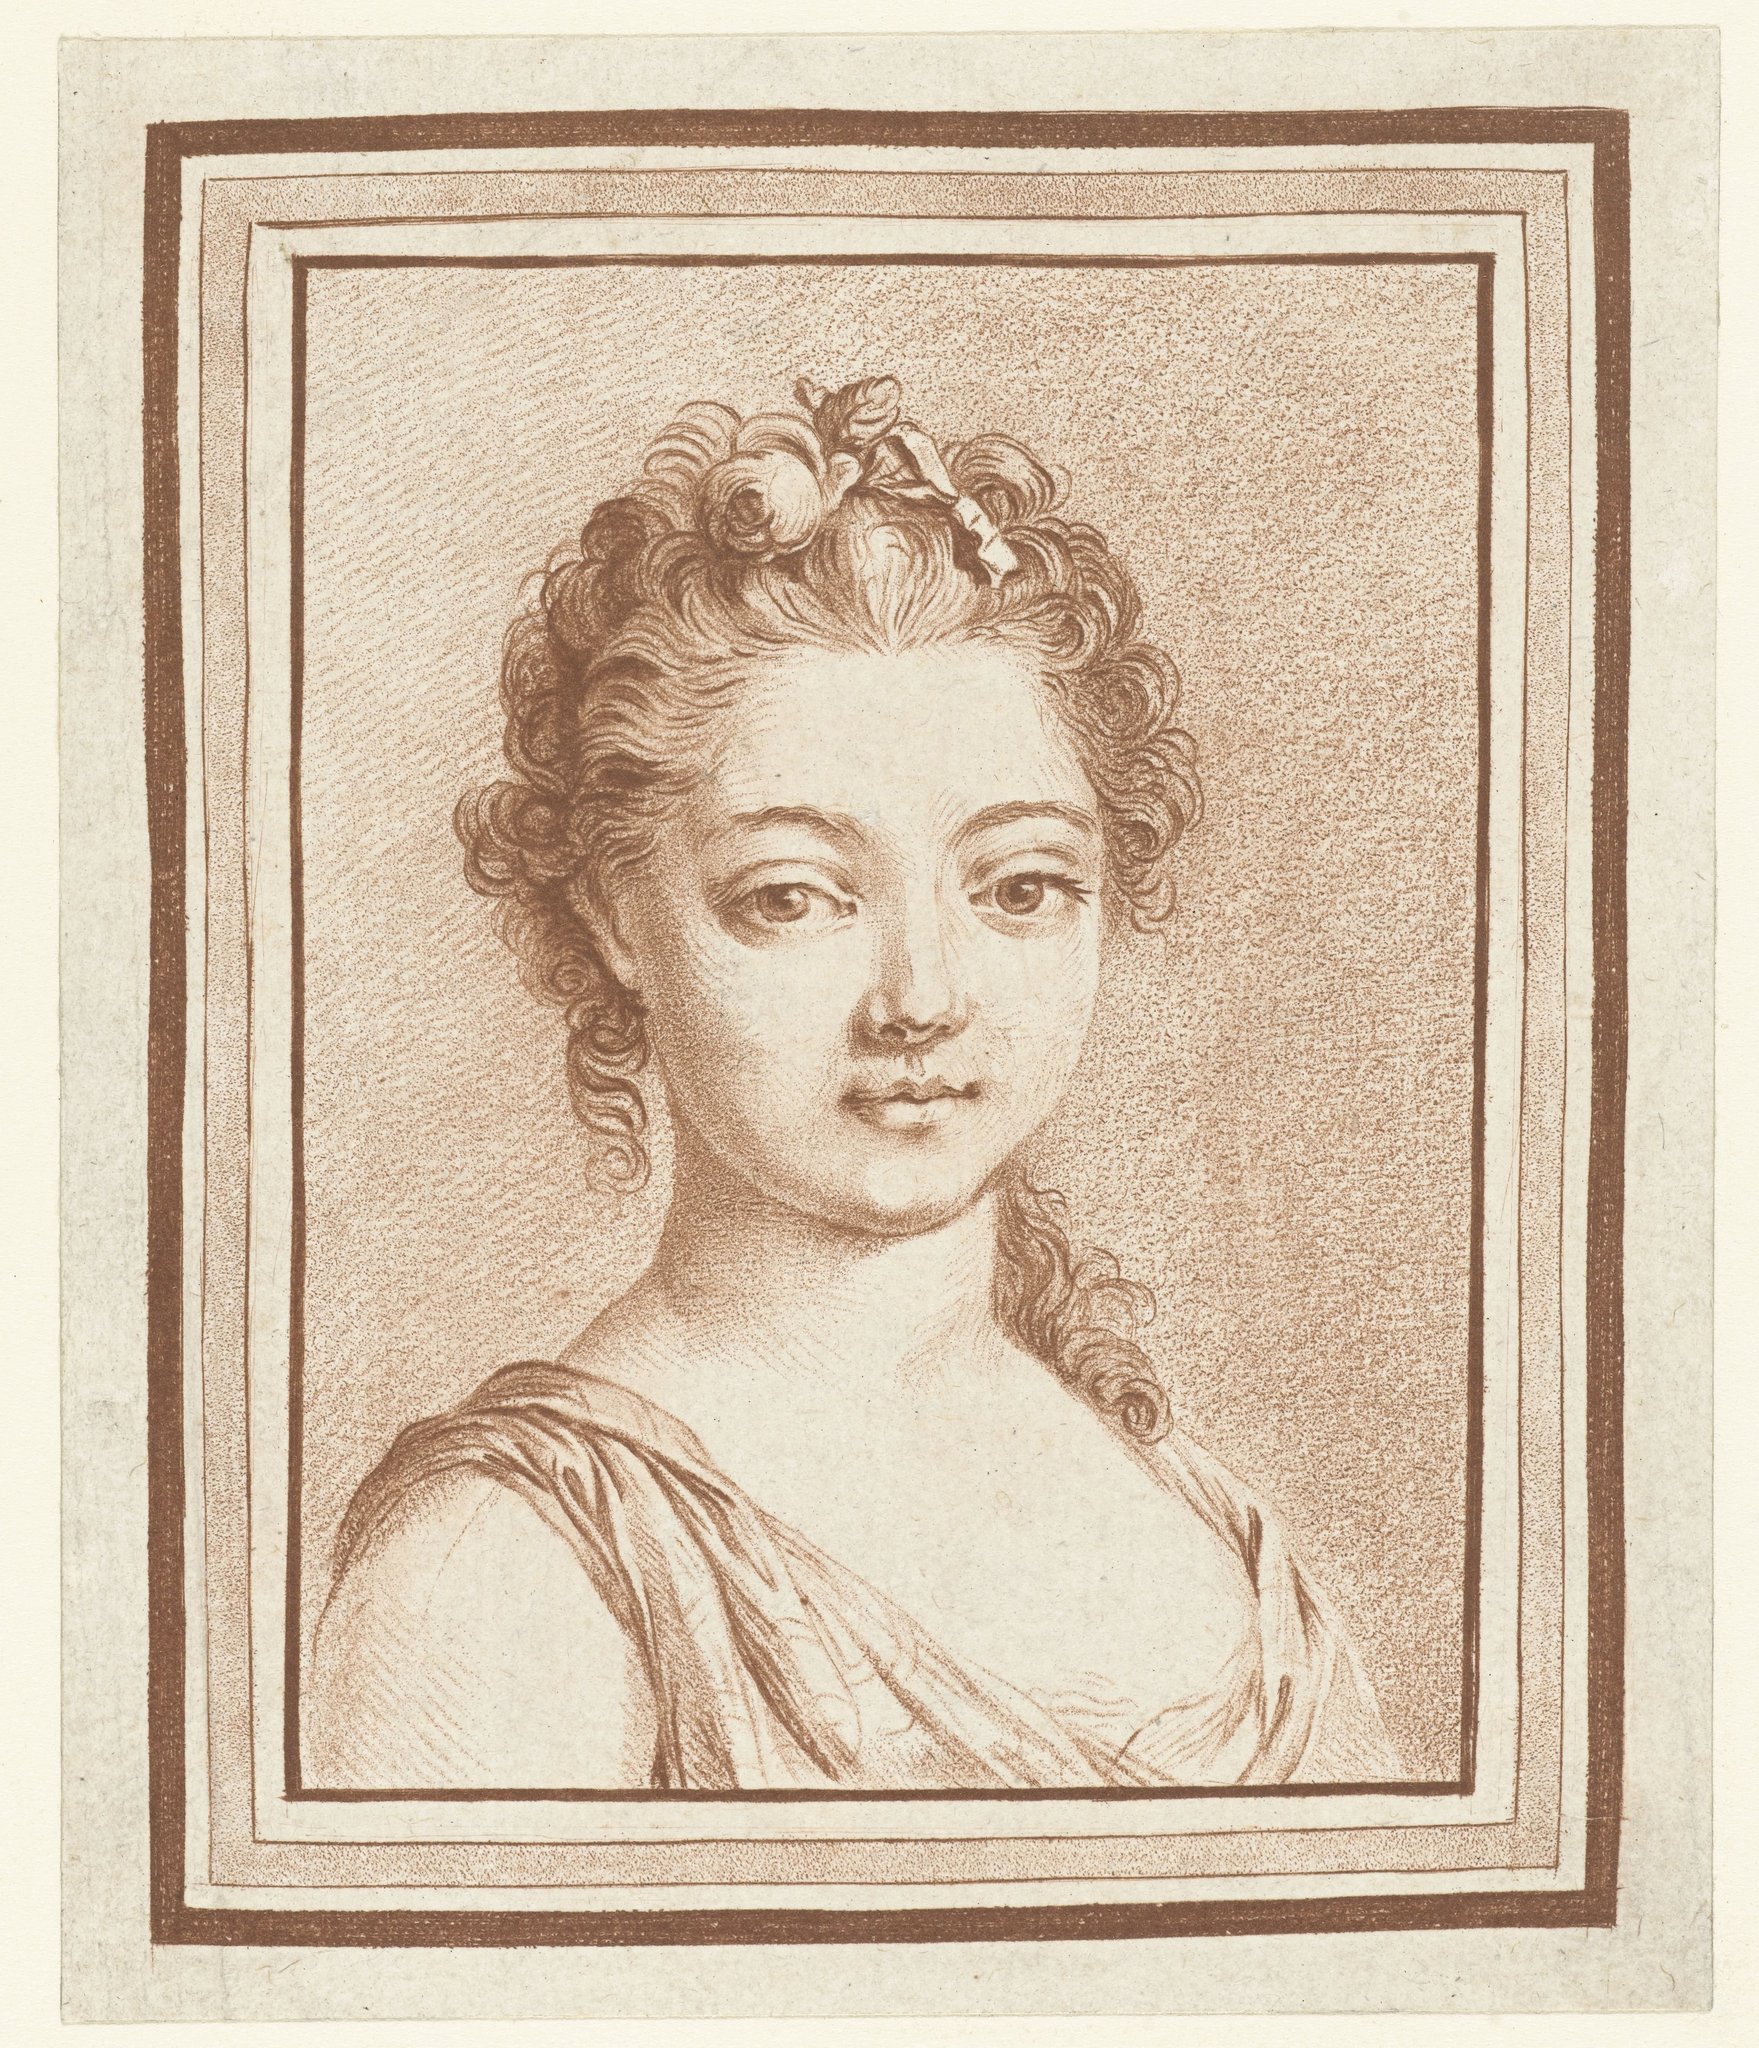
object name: print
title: Buste van een jong meisje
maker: louis marin bonnet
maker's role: print maker, publisher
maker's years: 1736-1793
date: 1757-1793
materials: paper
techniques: printmaking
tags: head (human) - aa - female human figure (+ front view)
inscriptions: collector's mark: Lugt 2228, inscription: ‘AC’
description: Buste van een jonge meisje met krullend haar, in een rechtshoekige omlijsting.